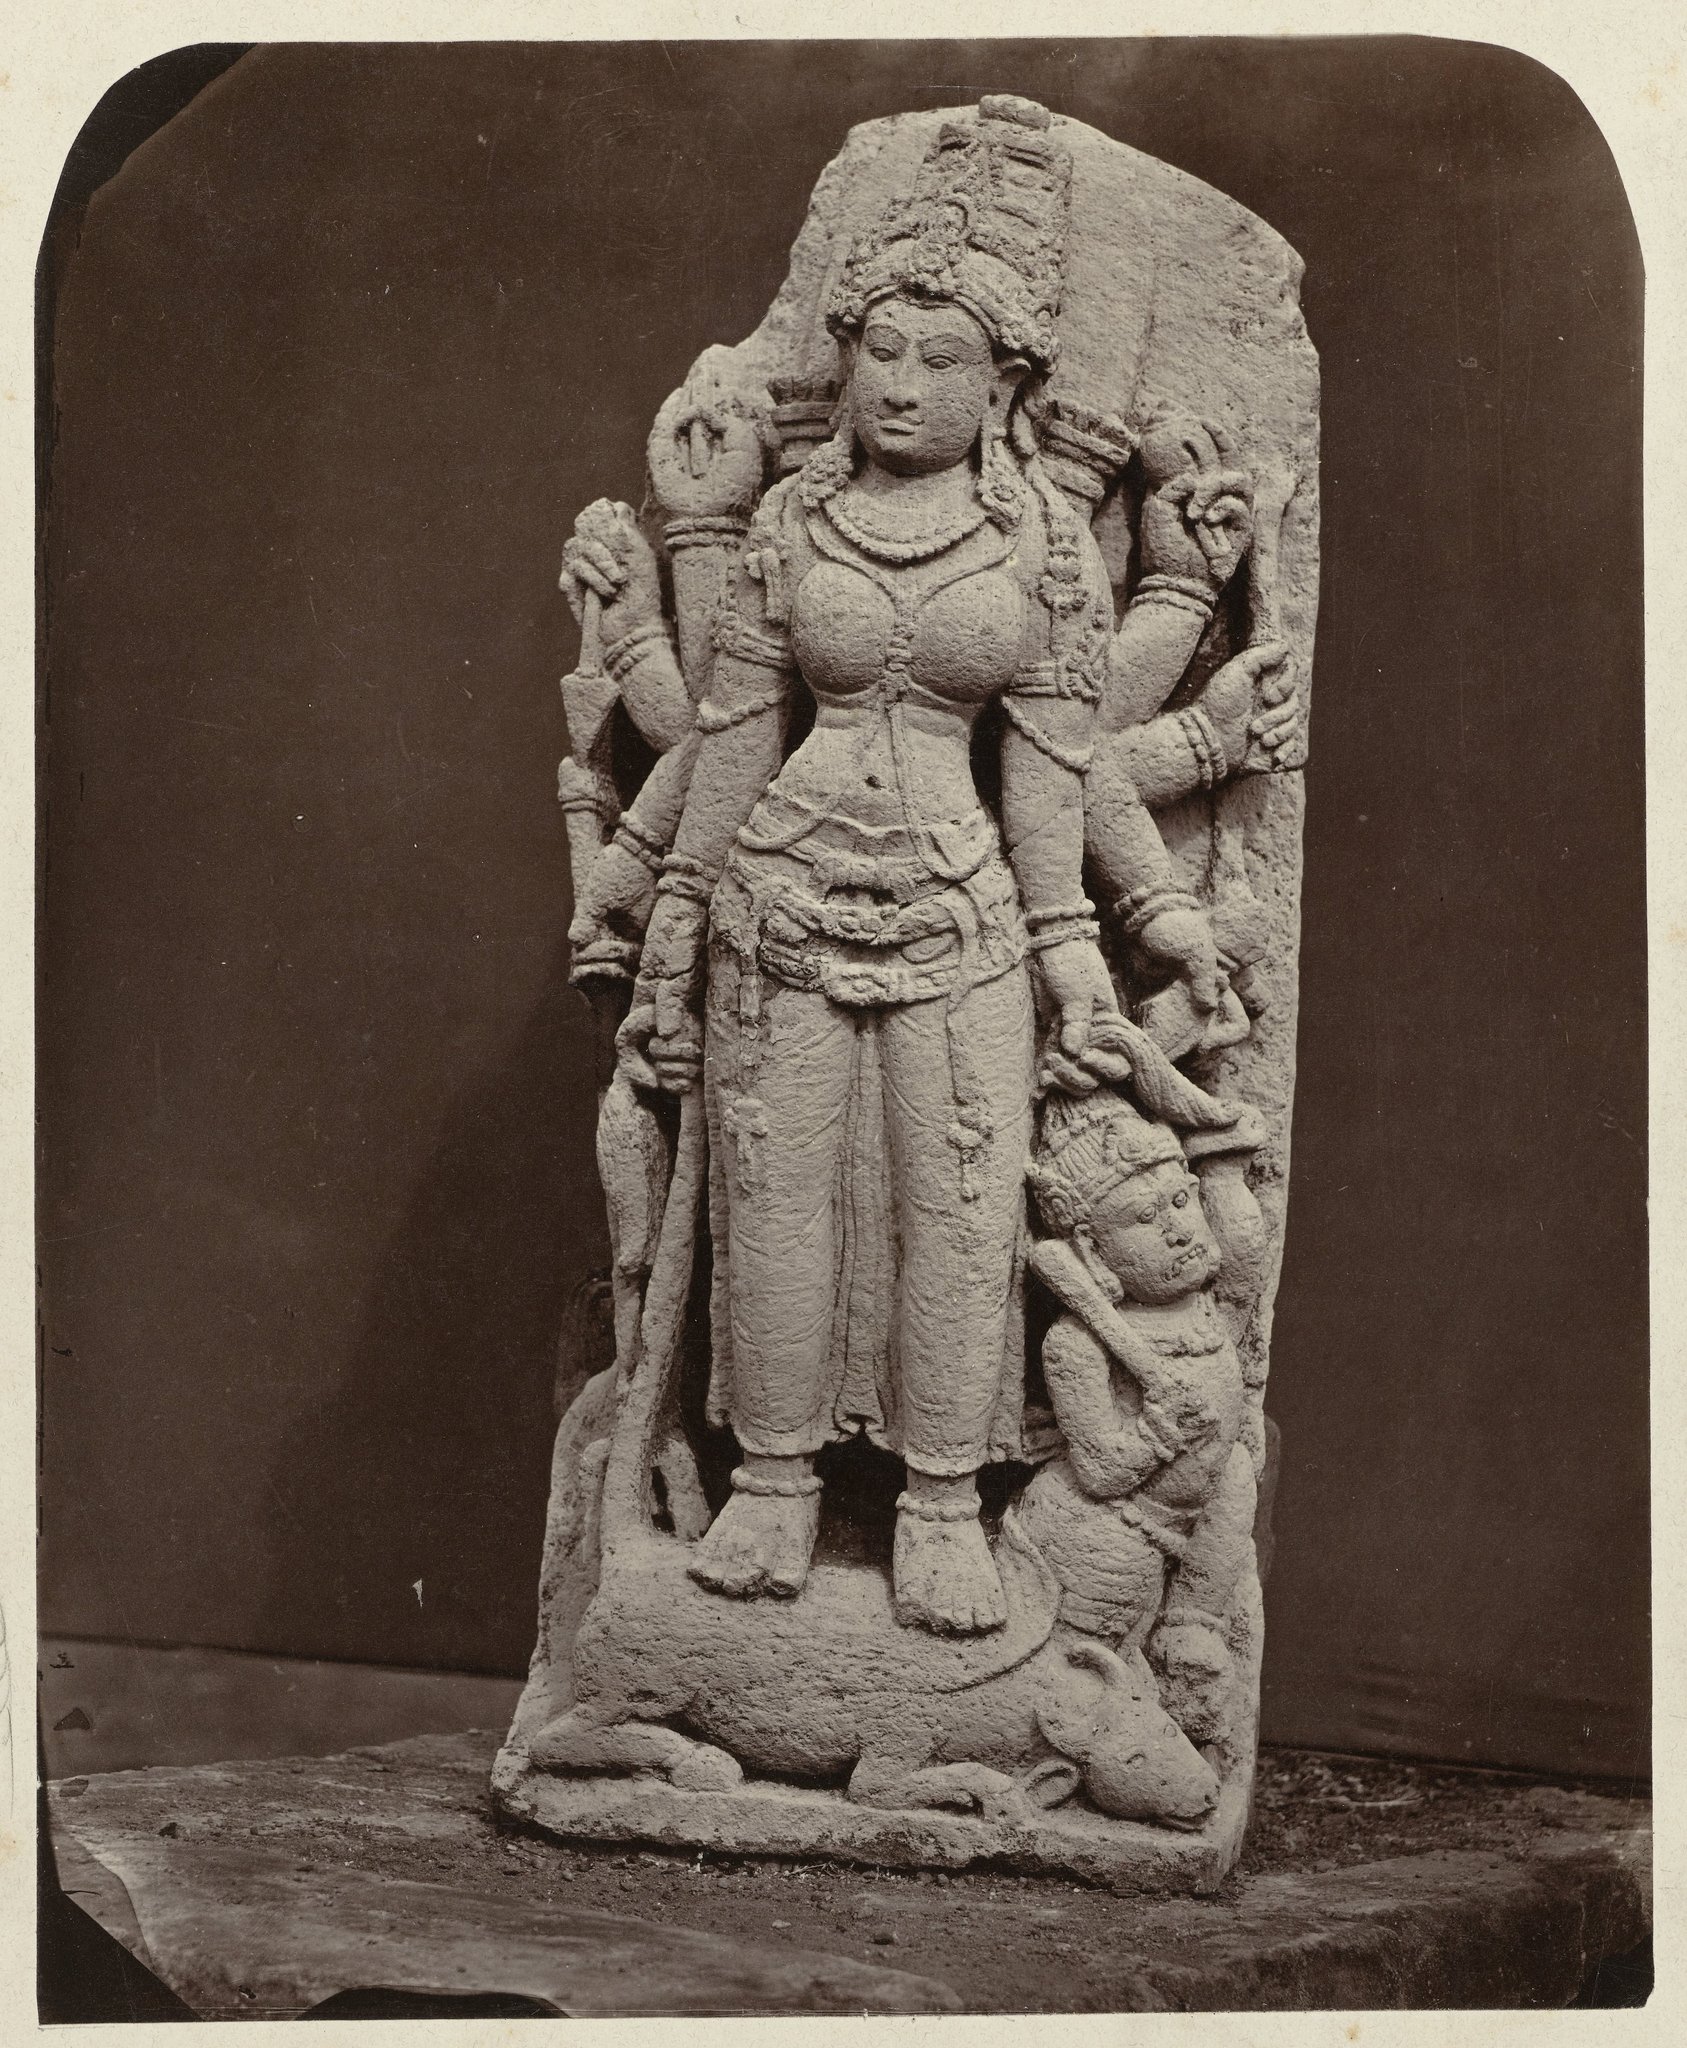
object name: photograph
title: Eight armed Durga slaying the demon Mahisha. Dieng Plateau, Wonosobo district, Central Java province 9th- 10th century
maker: isidore kinsbergen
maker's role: fotograaf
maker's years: 1821-1905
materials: cardboard, paper, photographic support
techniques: albumen print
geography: java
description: De godin Durga staat op de verslagen demonen leider Mahisha die de vorm van een buffel aan heeft genomen